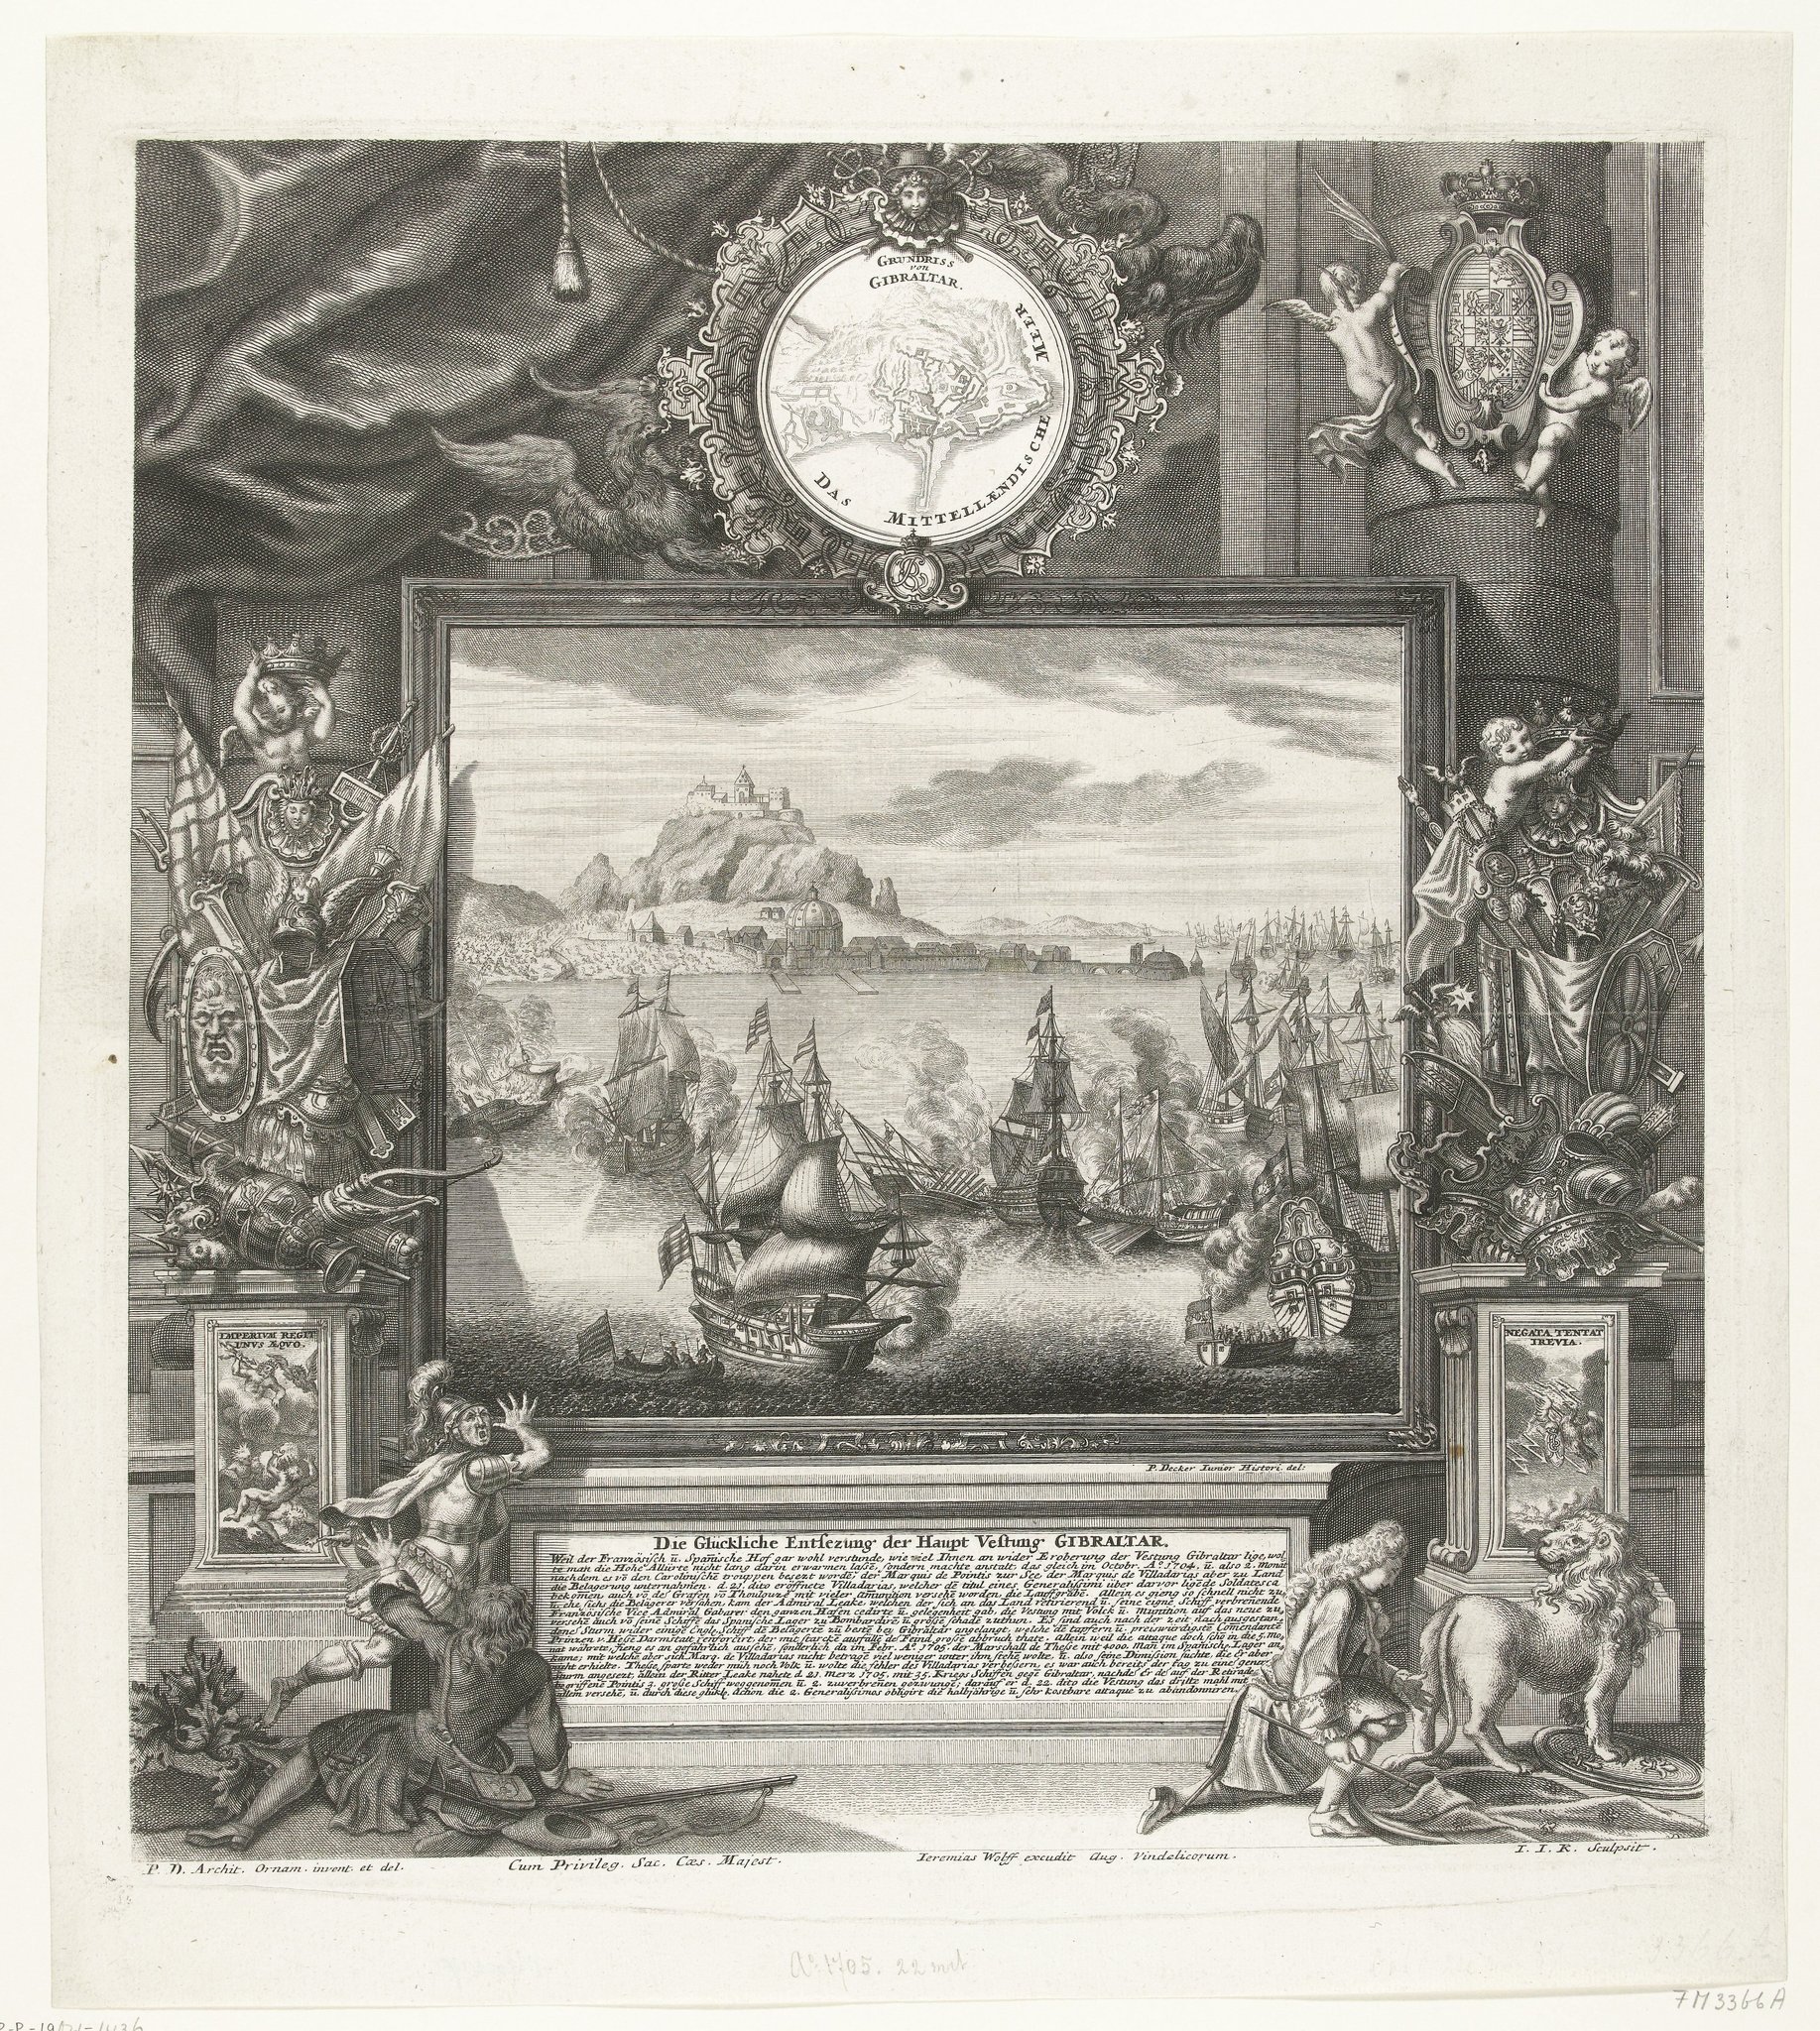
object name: print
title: Ontzet van Gibraltar, 1705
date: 1712-1715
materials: paper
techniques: engraving, etching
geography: augsburg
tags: battle (+ naval force)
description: Zeeslag bij Gibraltar op 21 maart 1705 met een overwinning van de Engelse vloot op de Franse vloot. Hiermee kwam een eind aan het beleg van Gibraltar door de Fransen en Spanjaarden. Voorstelling van de zeeslag in een grote ornamentele omlijsting met wapentrofeeën, cartouches met emblemen, het Engelse koningswapen en enkele figuren. Bovenaan een plattegrond van Gibraltar. Onderaan een cartouche met de beschrijving van het gevecht in het Duits, links vluchtende soldaten, rechts onderwerpt een Franse officier zich aan de Nederlandse Leeuw.